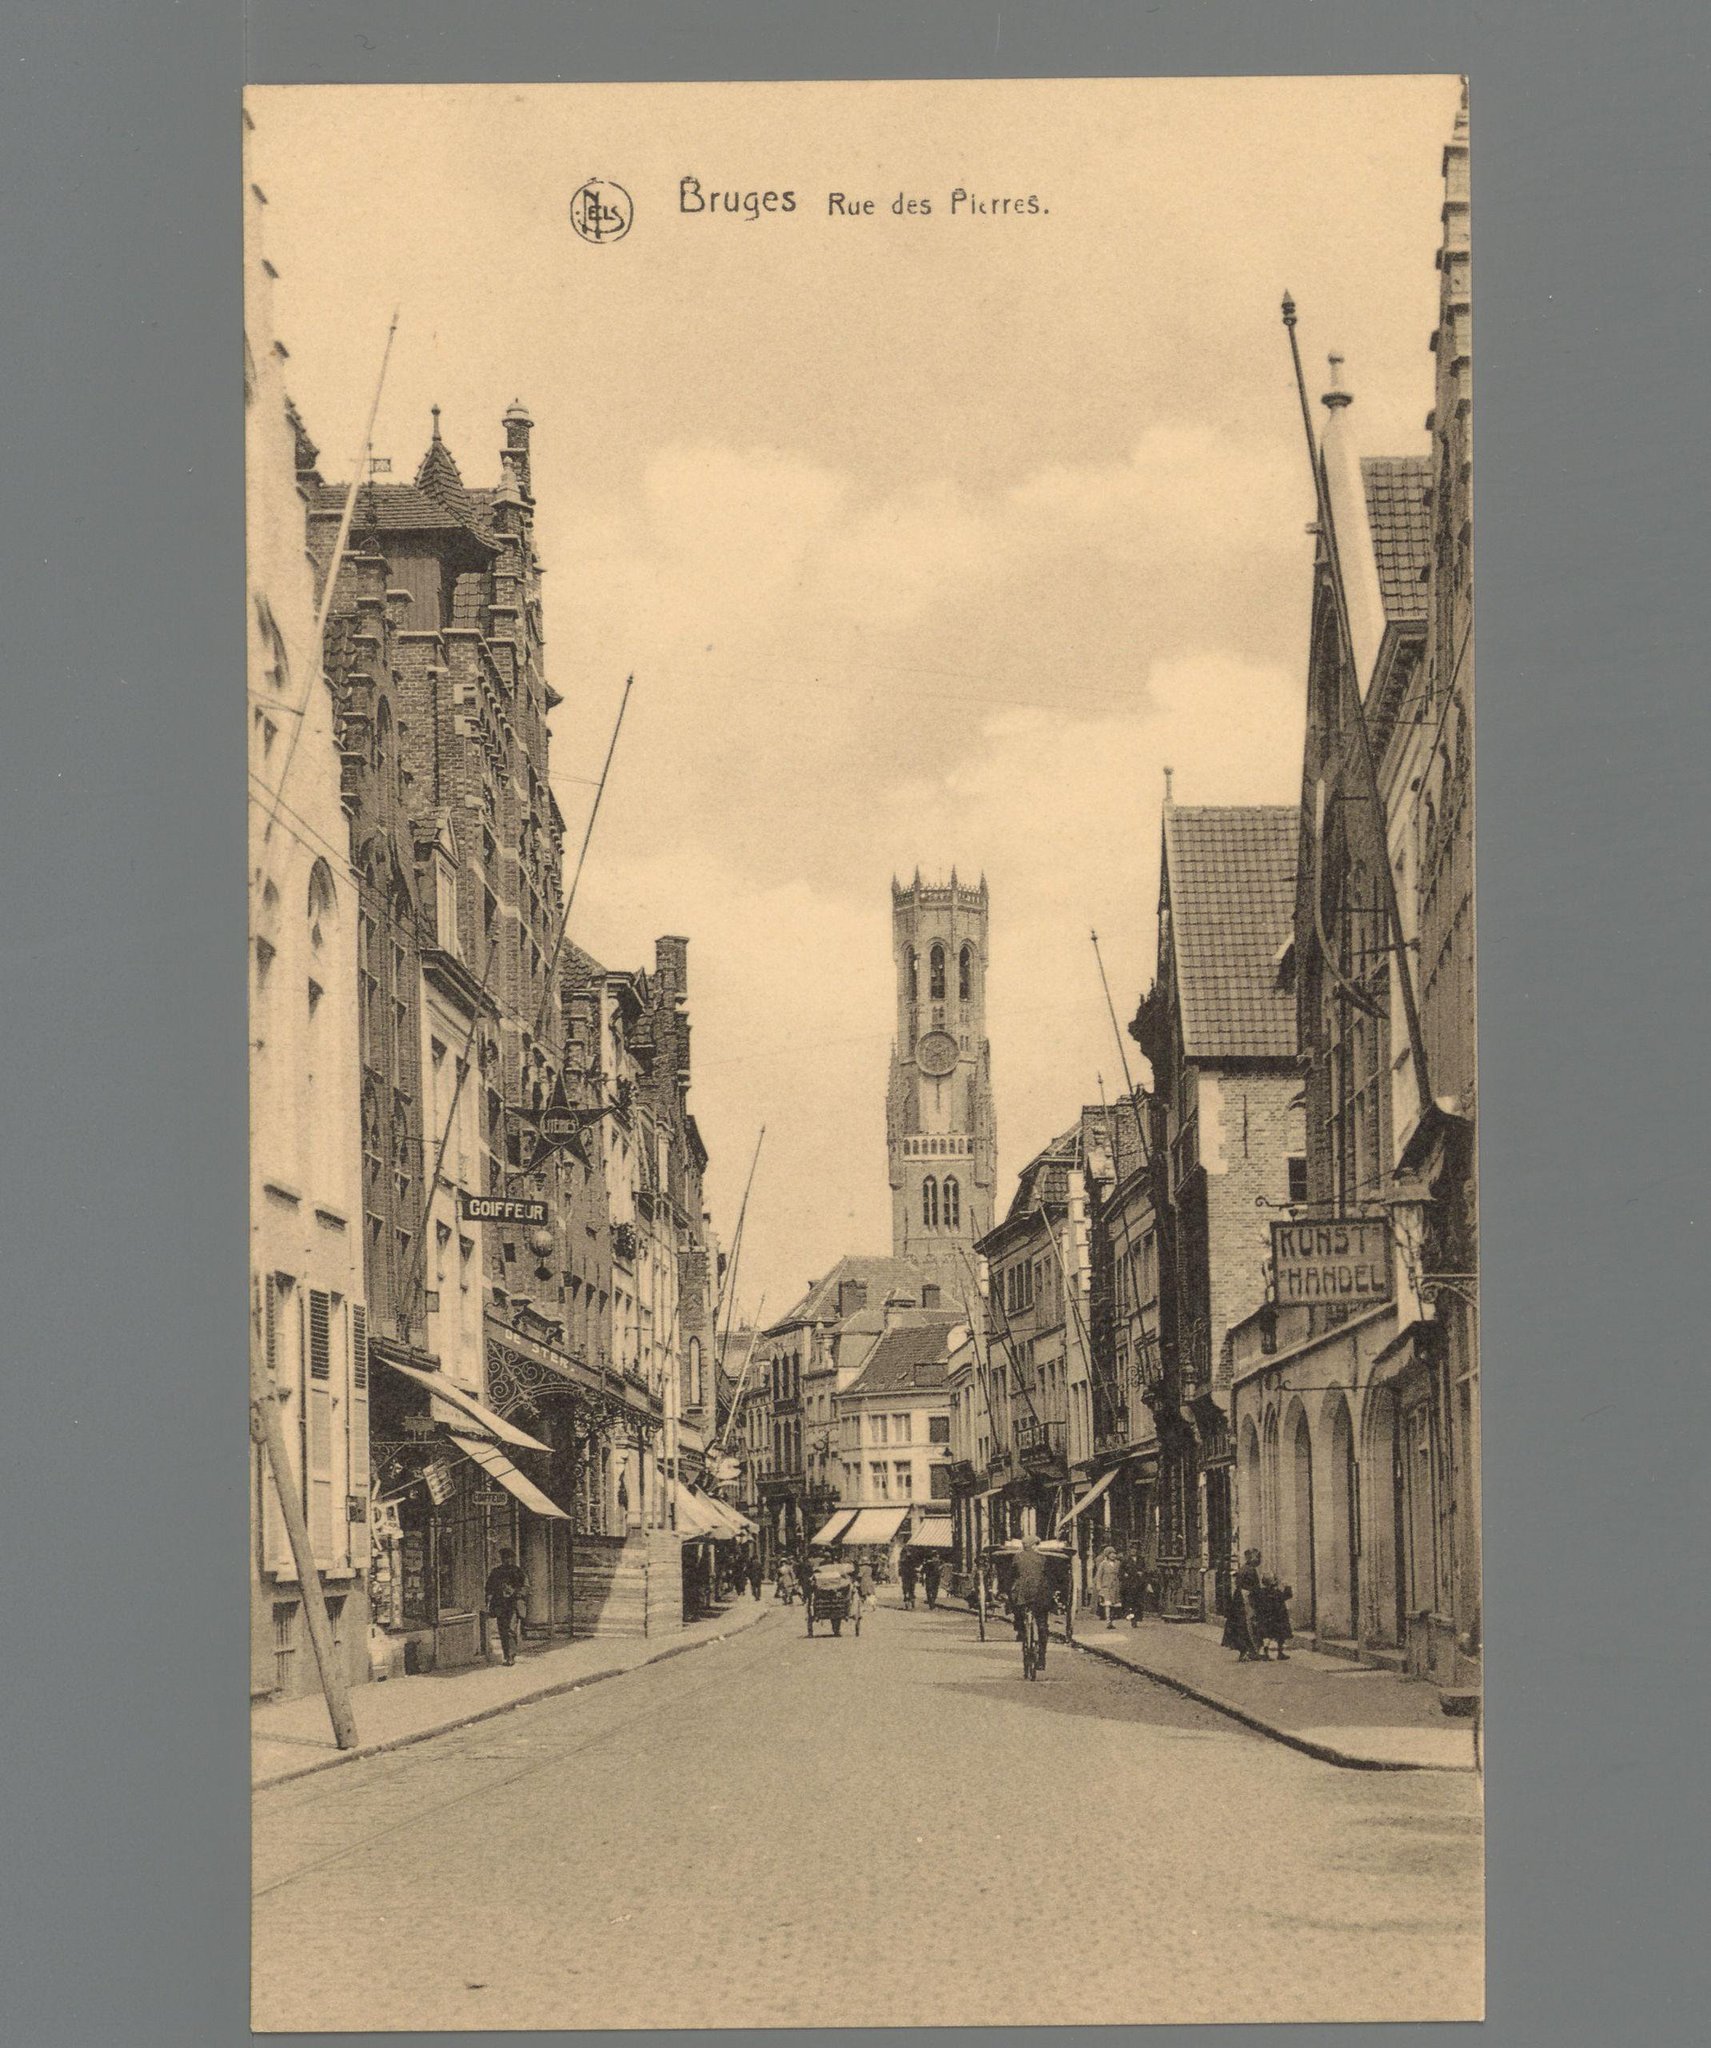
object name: photomechanical print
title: Série 12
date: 1913-1930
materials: cardboard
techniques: photograph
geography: bruges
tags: tower, clock tower ~ monumental adornment, street (+ city(-scape) with figures, staffage), bruges